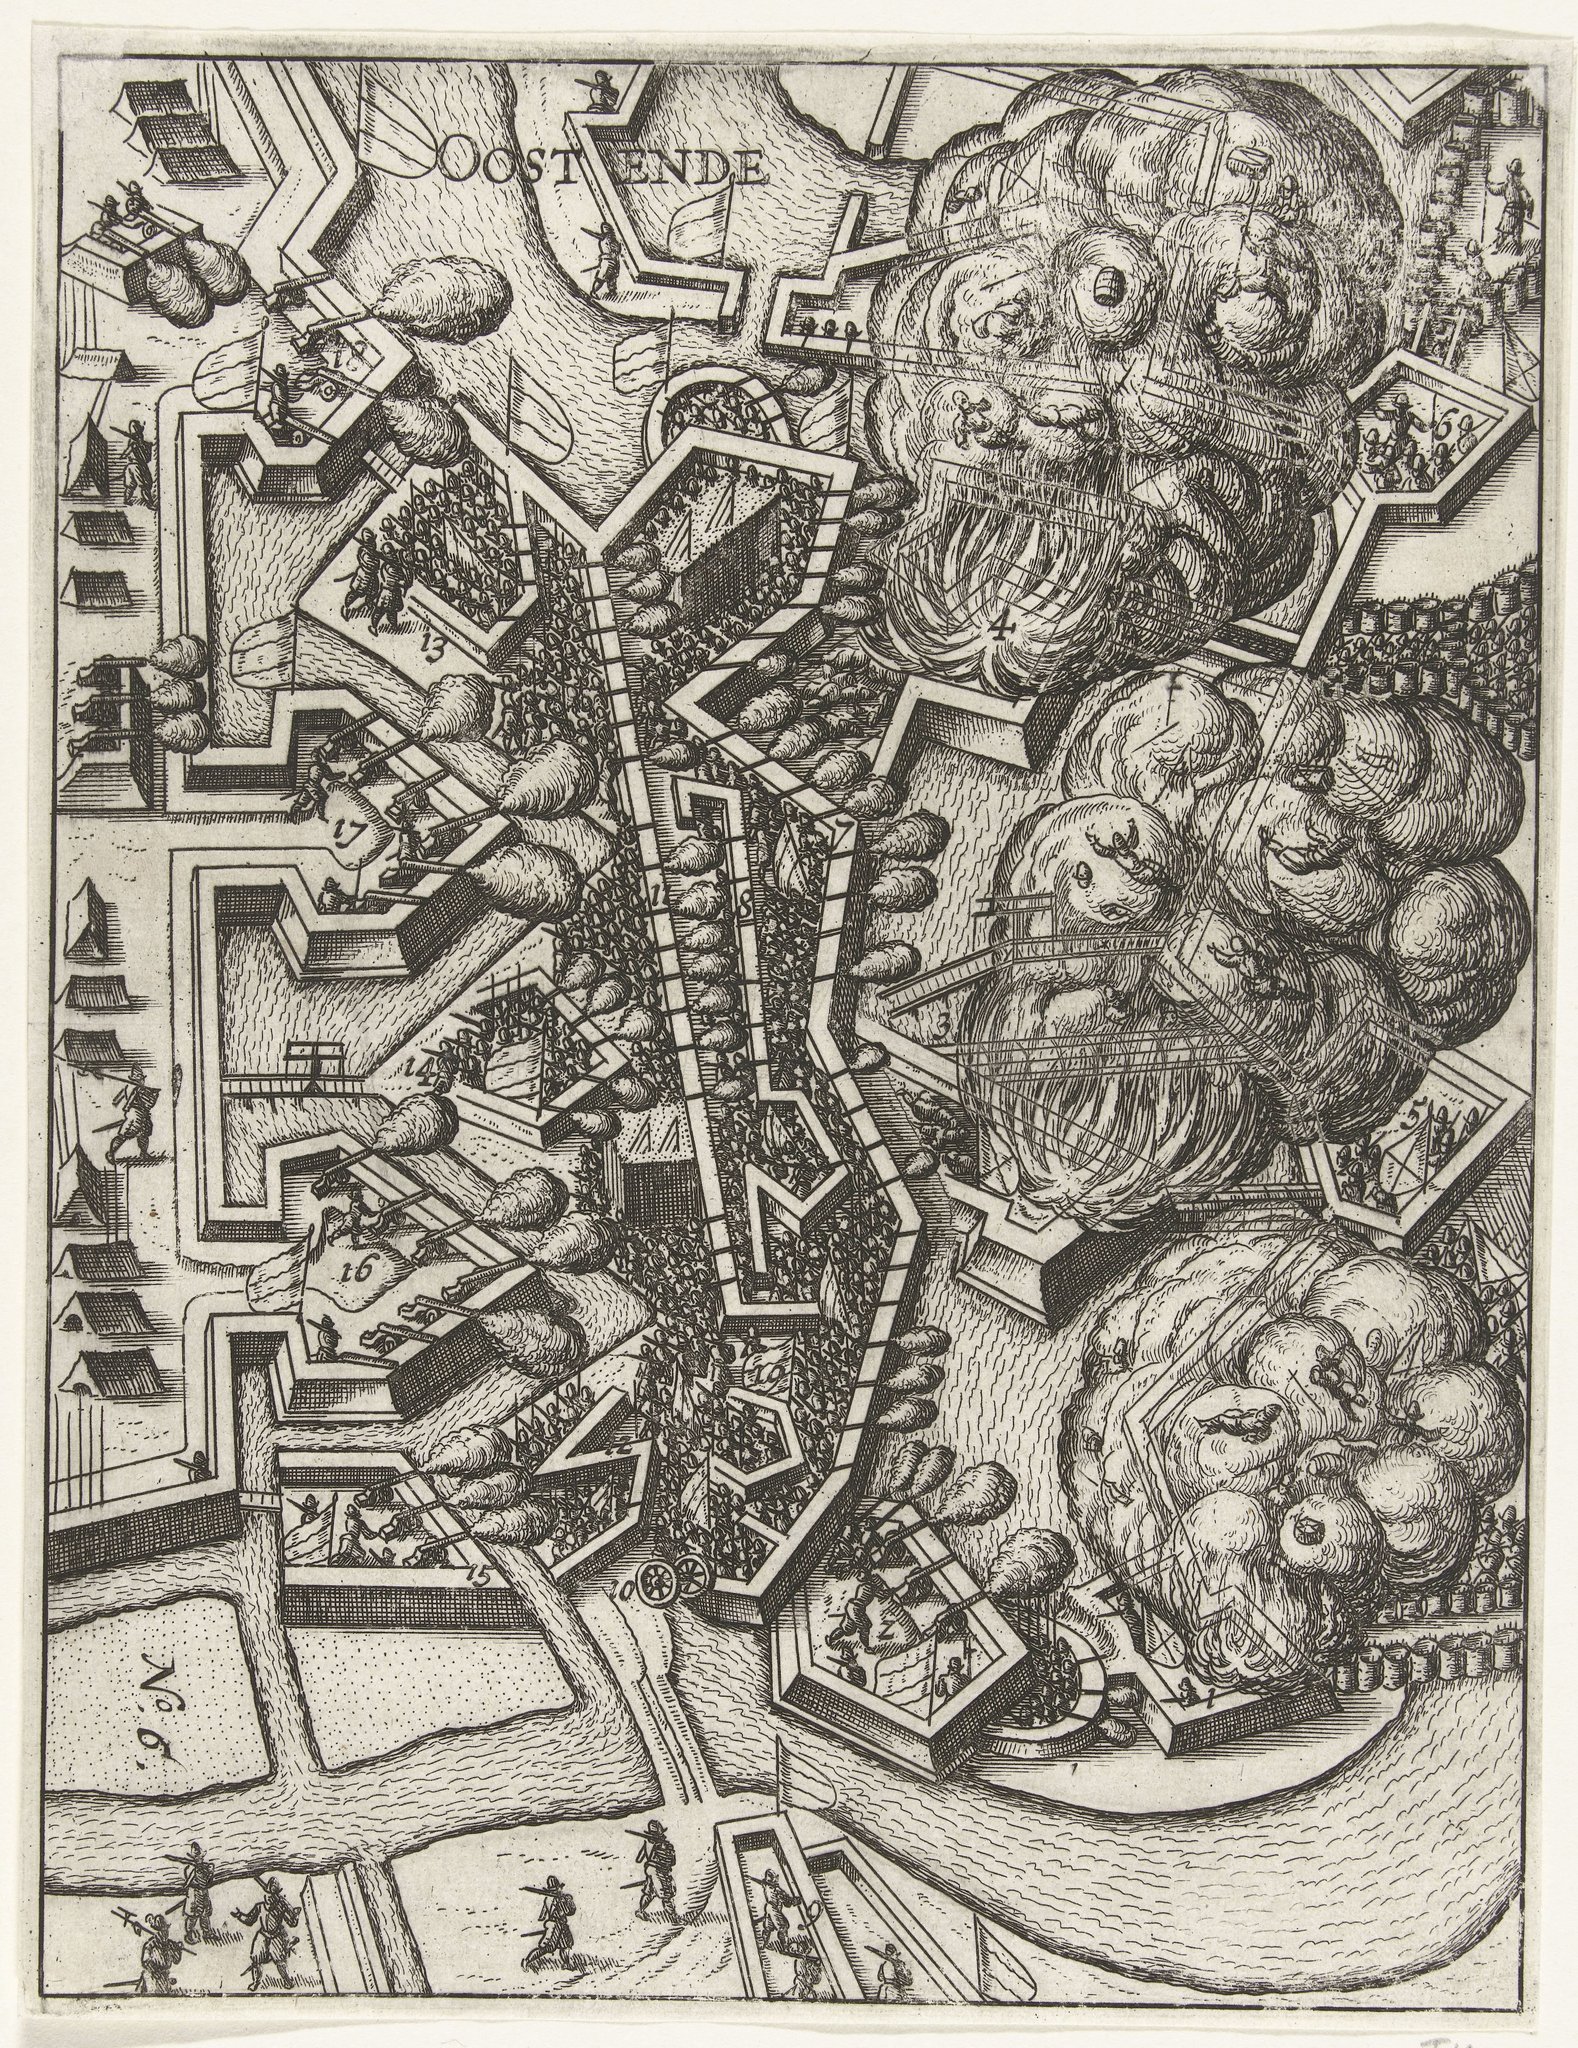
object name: print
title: Beleg van Oostende: gevechten en ontploffingen onder de bolwerken, 1604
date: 1604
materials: paper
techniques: etching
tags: siege, position war, projectiles, explosives, etc.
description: Eerdere staat van prent ook gebruikt in contemporaine journalen van het beleg van Oostende uit 1604 (exemplaren in de collectie van de Rijksmuseum Research Library (326 F 10 en 326 F 11). En in: Haestens, Hendrick van. De Bloedige ende strenge Belegeringhe Der Stadt Oostende in Vlaenderen, Leiden: Hendrick van Haestens, 1613. Huidige staat van prent ook gebruikt in: Haestens, Hendrick van. La nouvelle Troye ou memorable histoire du siege d’Ostende. Leiden: Hendrick van Haestens, 1615.